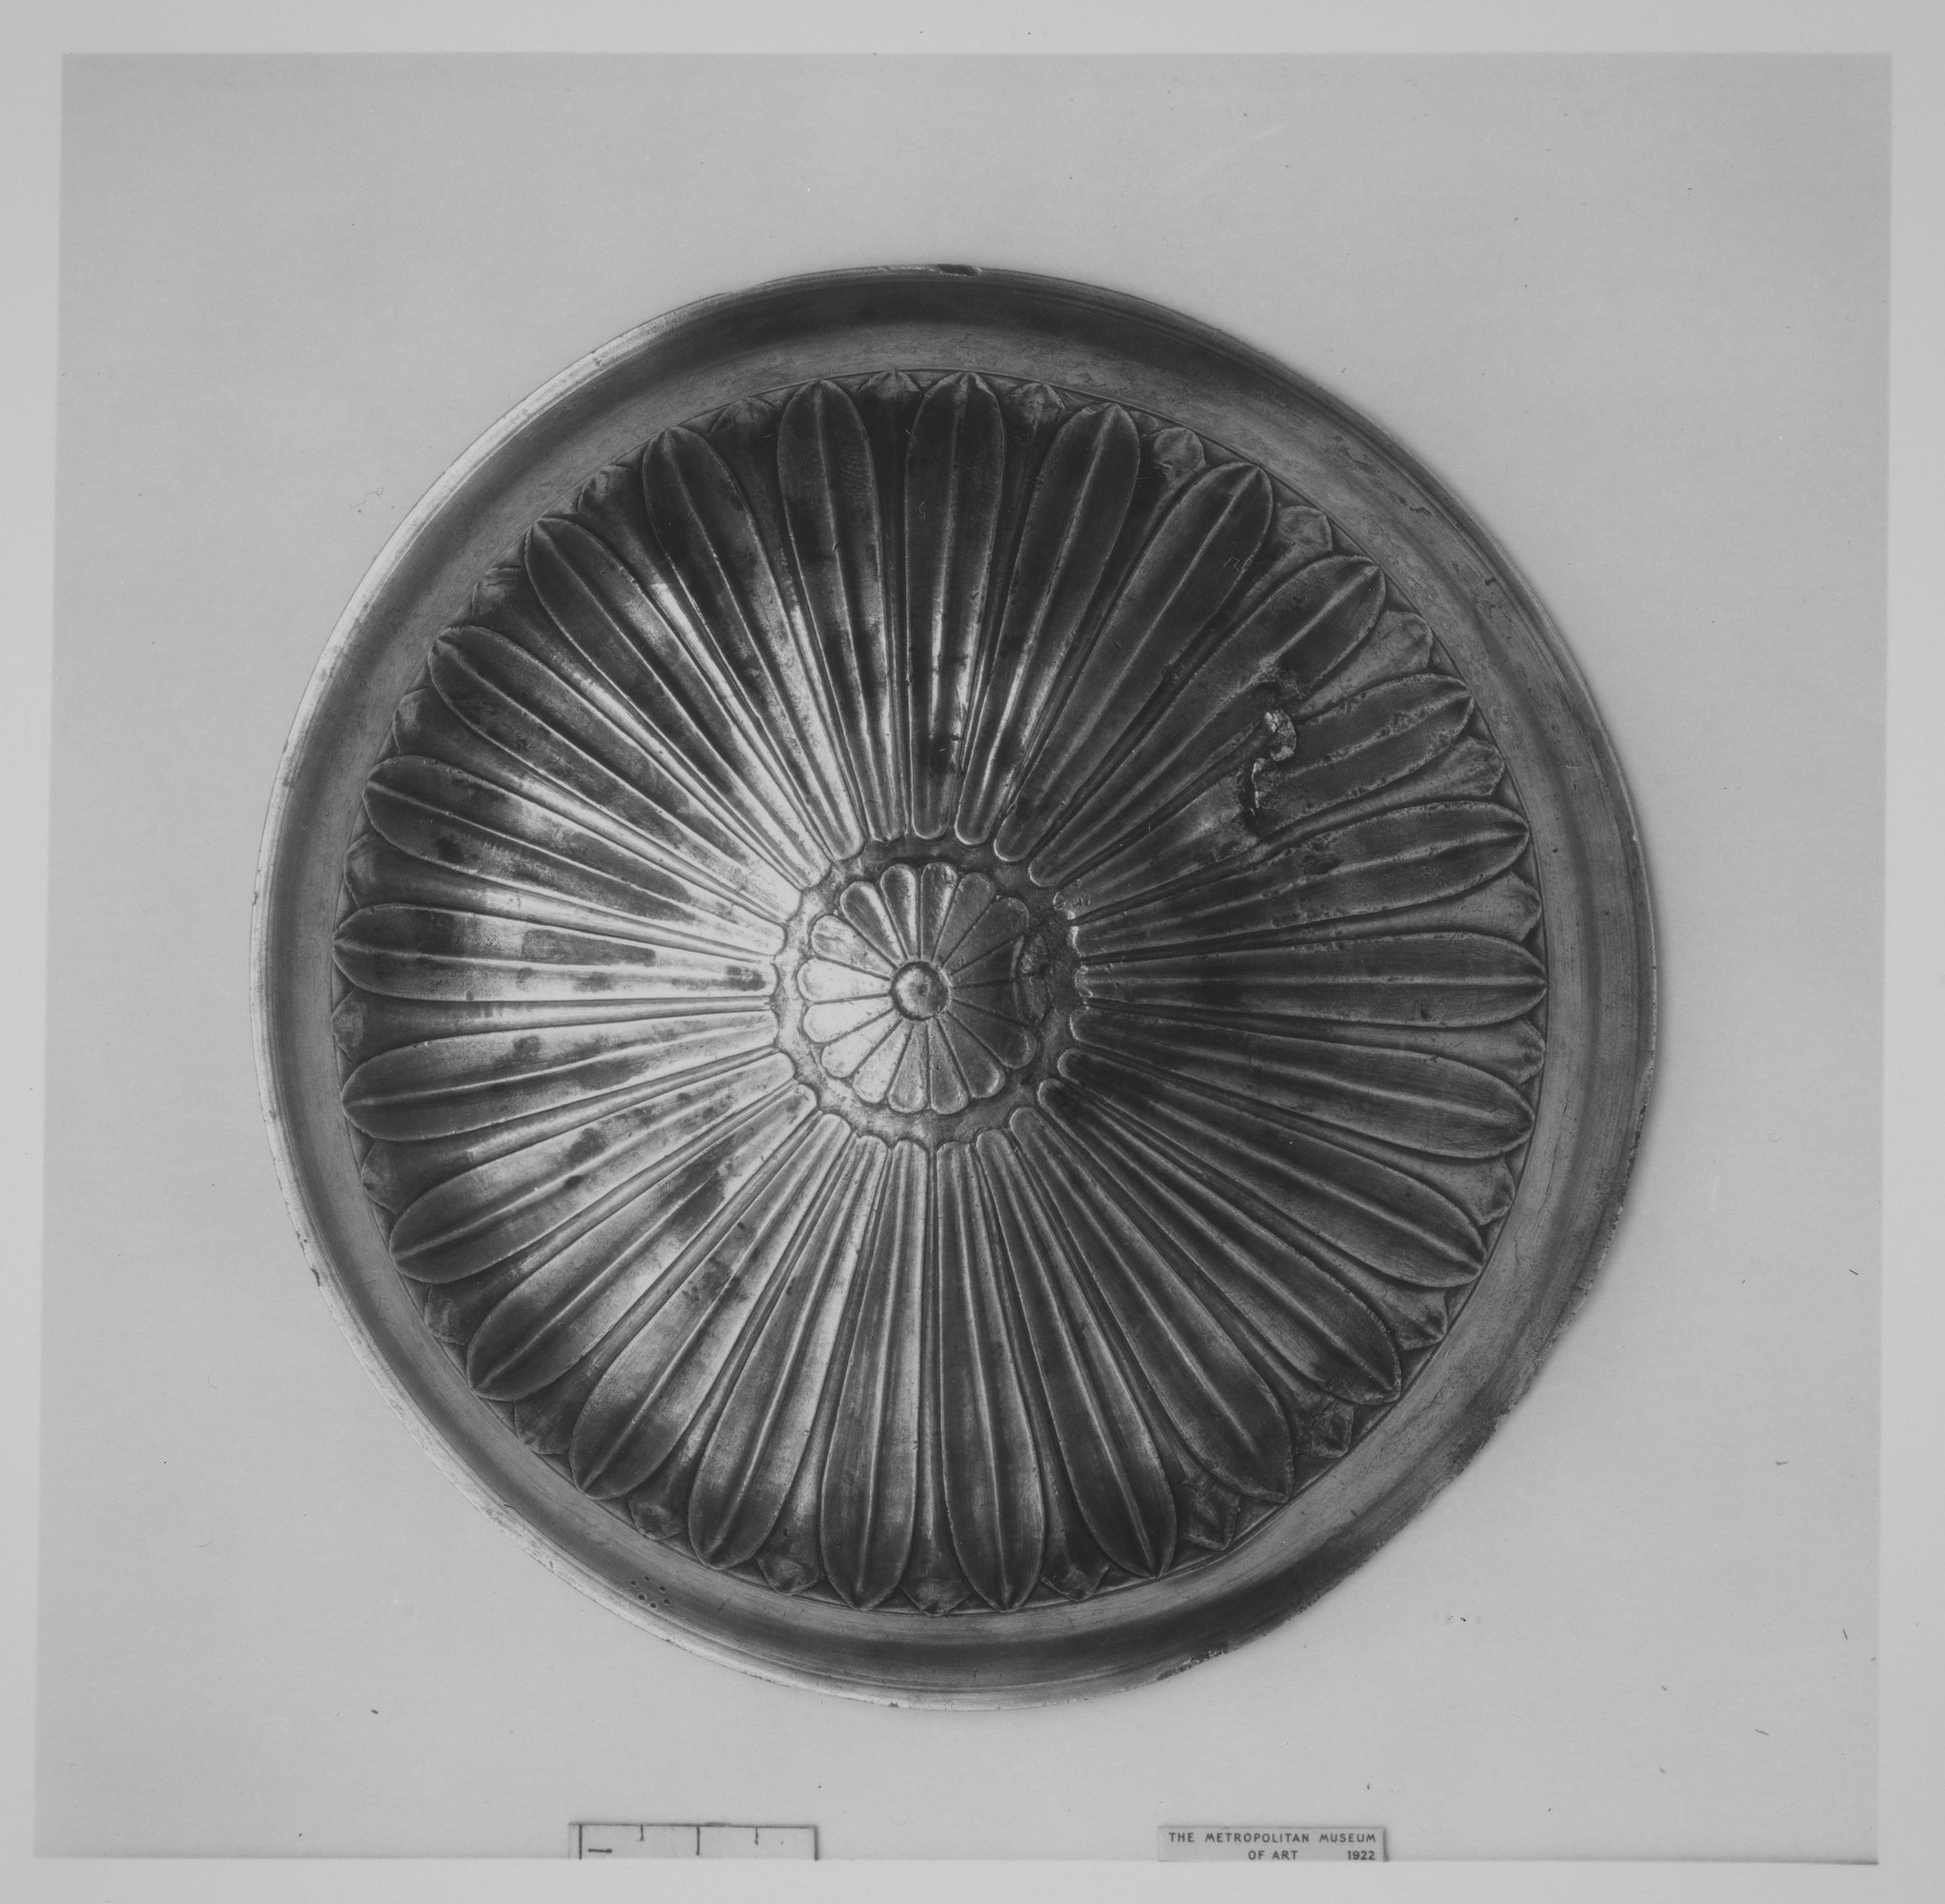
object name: bowl with gilding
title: Silver phiale (libation bowl) with gilding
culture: greek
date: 400-301 BCE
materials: gold, silver